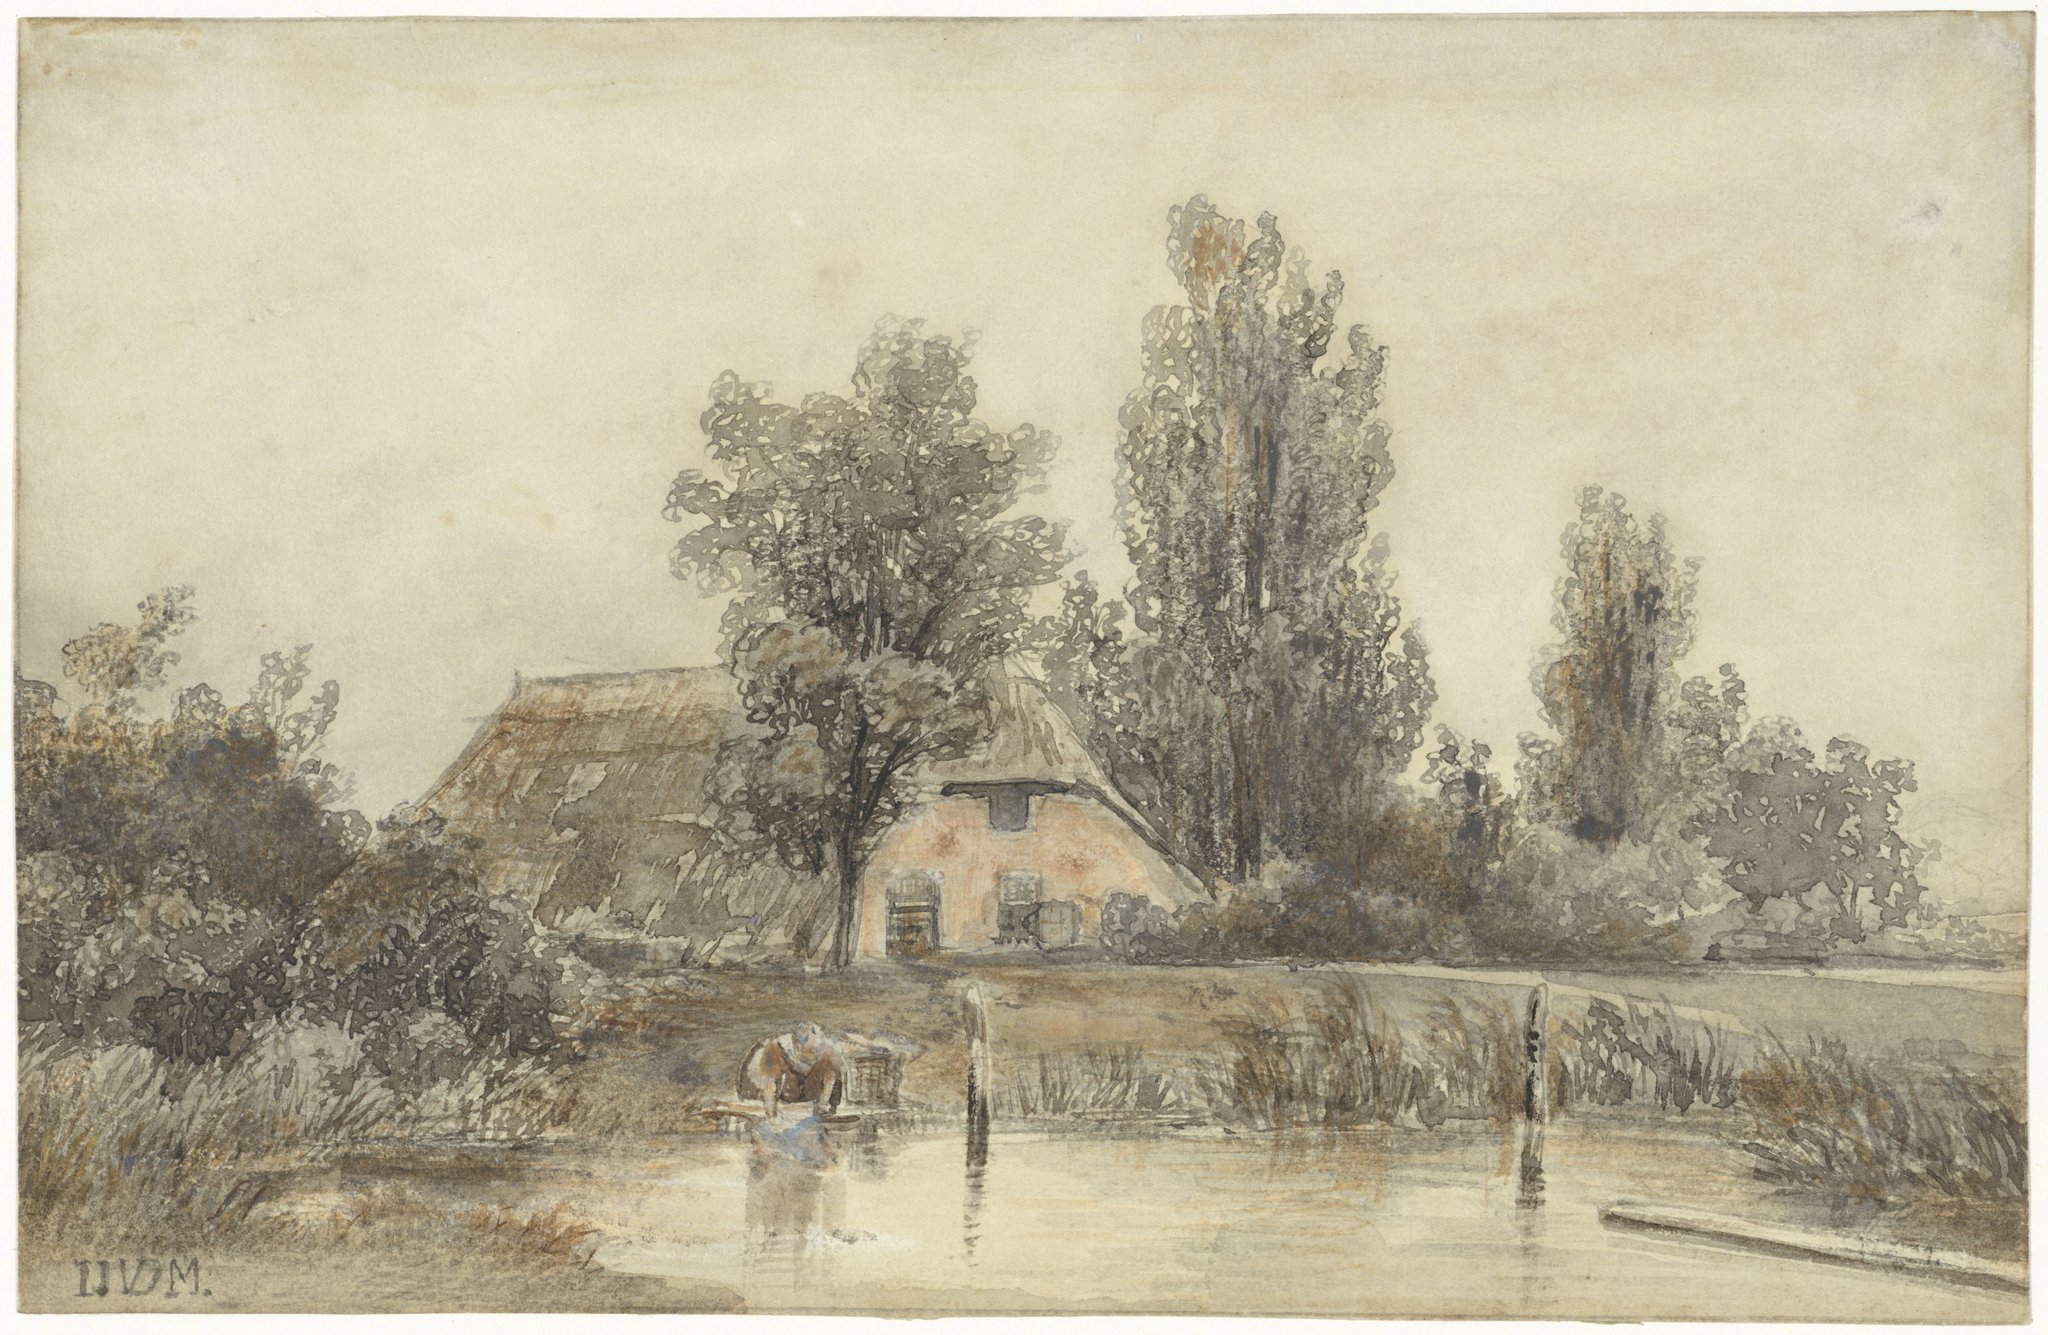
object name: drawing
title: Boerderij en een wassende vrouw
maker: jacob jan van der maaten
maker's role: draughtsman, print maker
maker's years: 1820-1879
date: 1830-1879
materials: paint, paper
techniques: brush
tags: farm (building)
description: Boerderij tussen bomen en wassende vrouw bij het water.